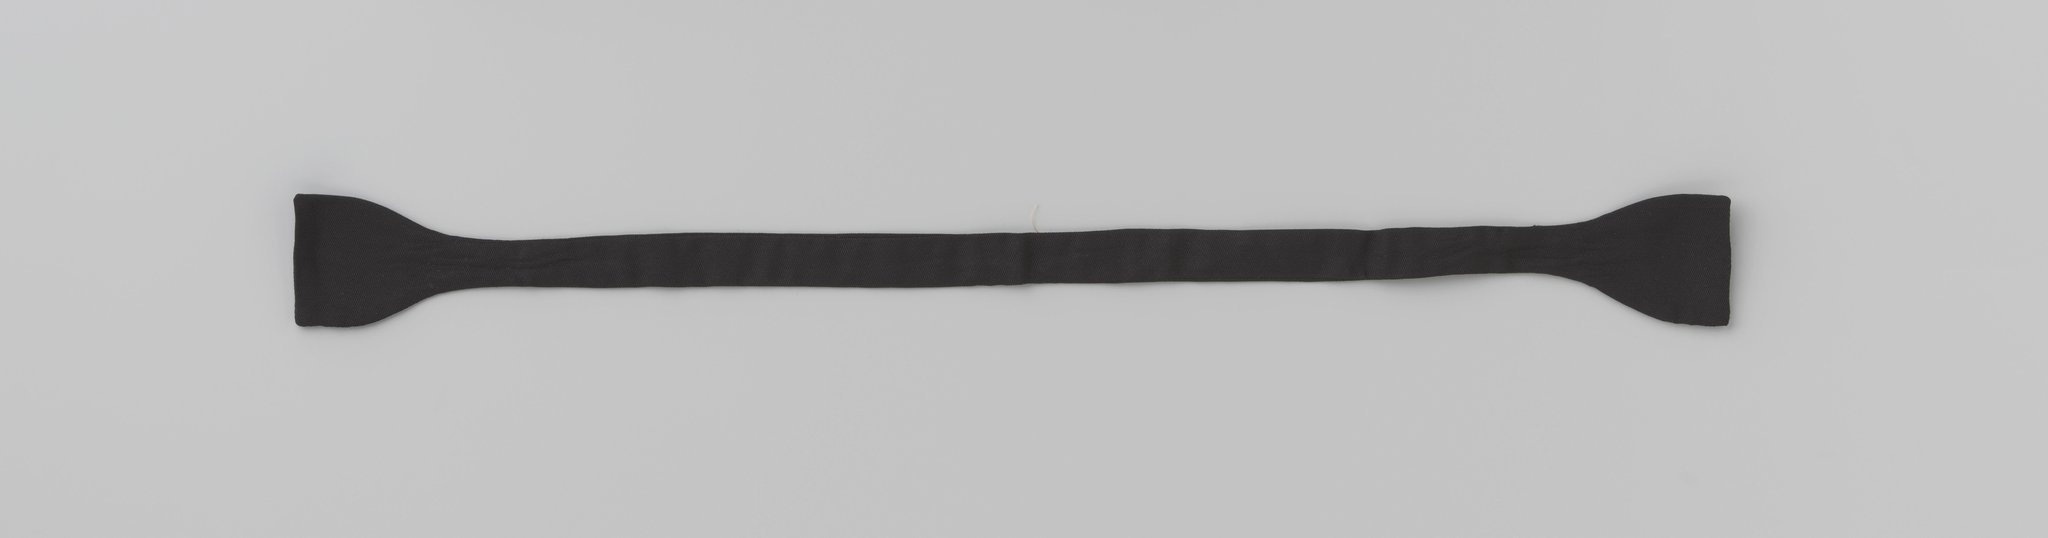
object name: bow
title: Zwarte strik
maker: Anonymous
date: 1920-1980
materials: textile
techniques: weave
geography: the hague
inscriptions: label: ‘GLörtzer DEN HAAG / Hoogstraat 32-32a / 56 cm’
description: Zwarte strik met aan de binnenzijde een label.